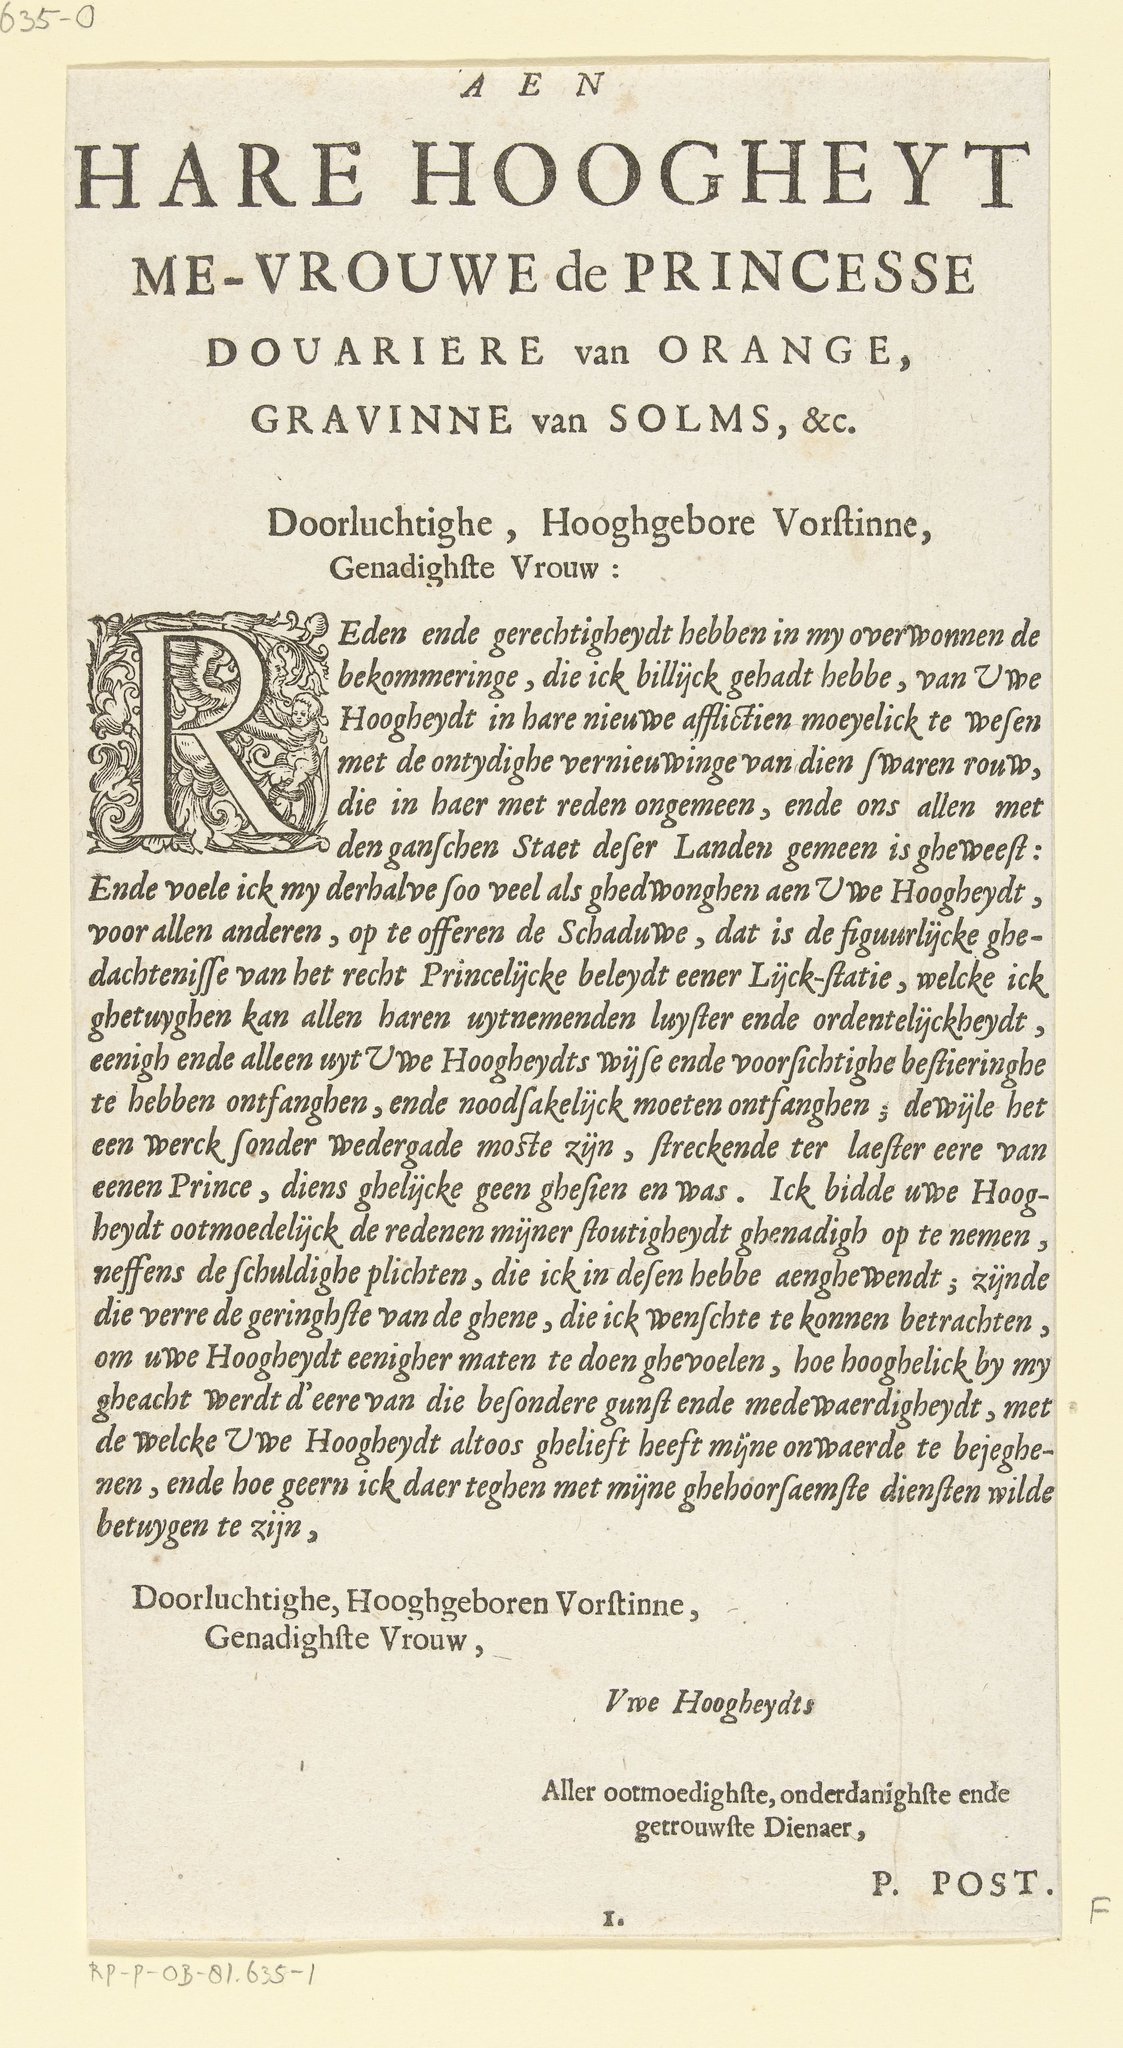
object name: text sheet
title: De begrafenisstoet van stadhouder Frederik Hendrik te 's-Gravenhage in 1647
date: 1651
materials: paper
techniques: letterpress printing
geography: amsterdam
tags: delft, the hague, frederick henry (prince of orange)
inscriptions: collector's mark:, collector's mark: Lugt 963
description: Tekstblad bij de prentserie van de begrafenisstoet van stadhouder Frederik Hendrik te 's-Gravenhage op 10 mei 1647. Tekstblad nr. 1 gericht aan Amalia van Solms. Onderdeel van een serie van 30 platen en 20 tekstbladen, bedoeld om aan elkaar geplakt te worden.